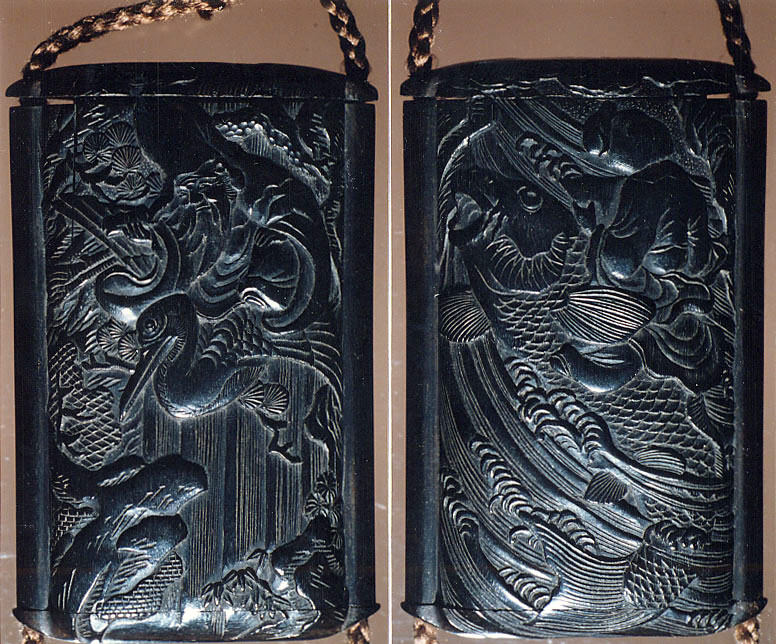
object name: inrō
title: Case (Inrō) with Design of Fukurokuju (God of Longevity) Riding a Flying Crane before Waterfall (obverse); Kinko Sennin Riding a Carp on Waves (reverse)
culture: japanese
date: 1801-1900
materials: wood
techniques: carving, relief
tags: cranes,fish,gods